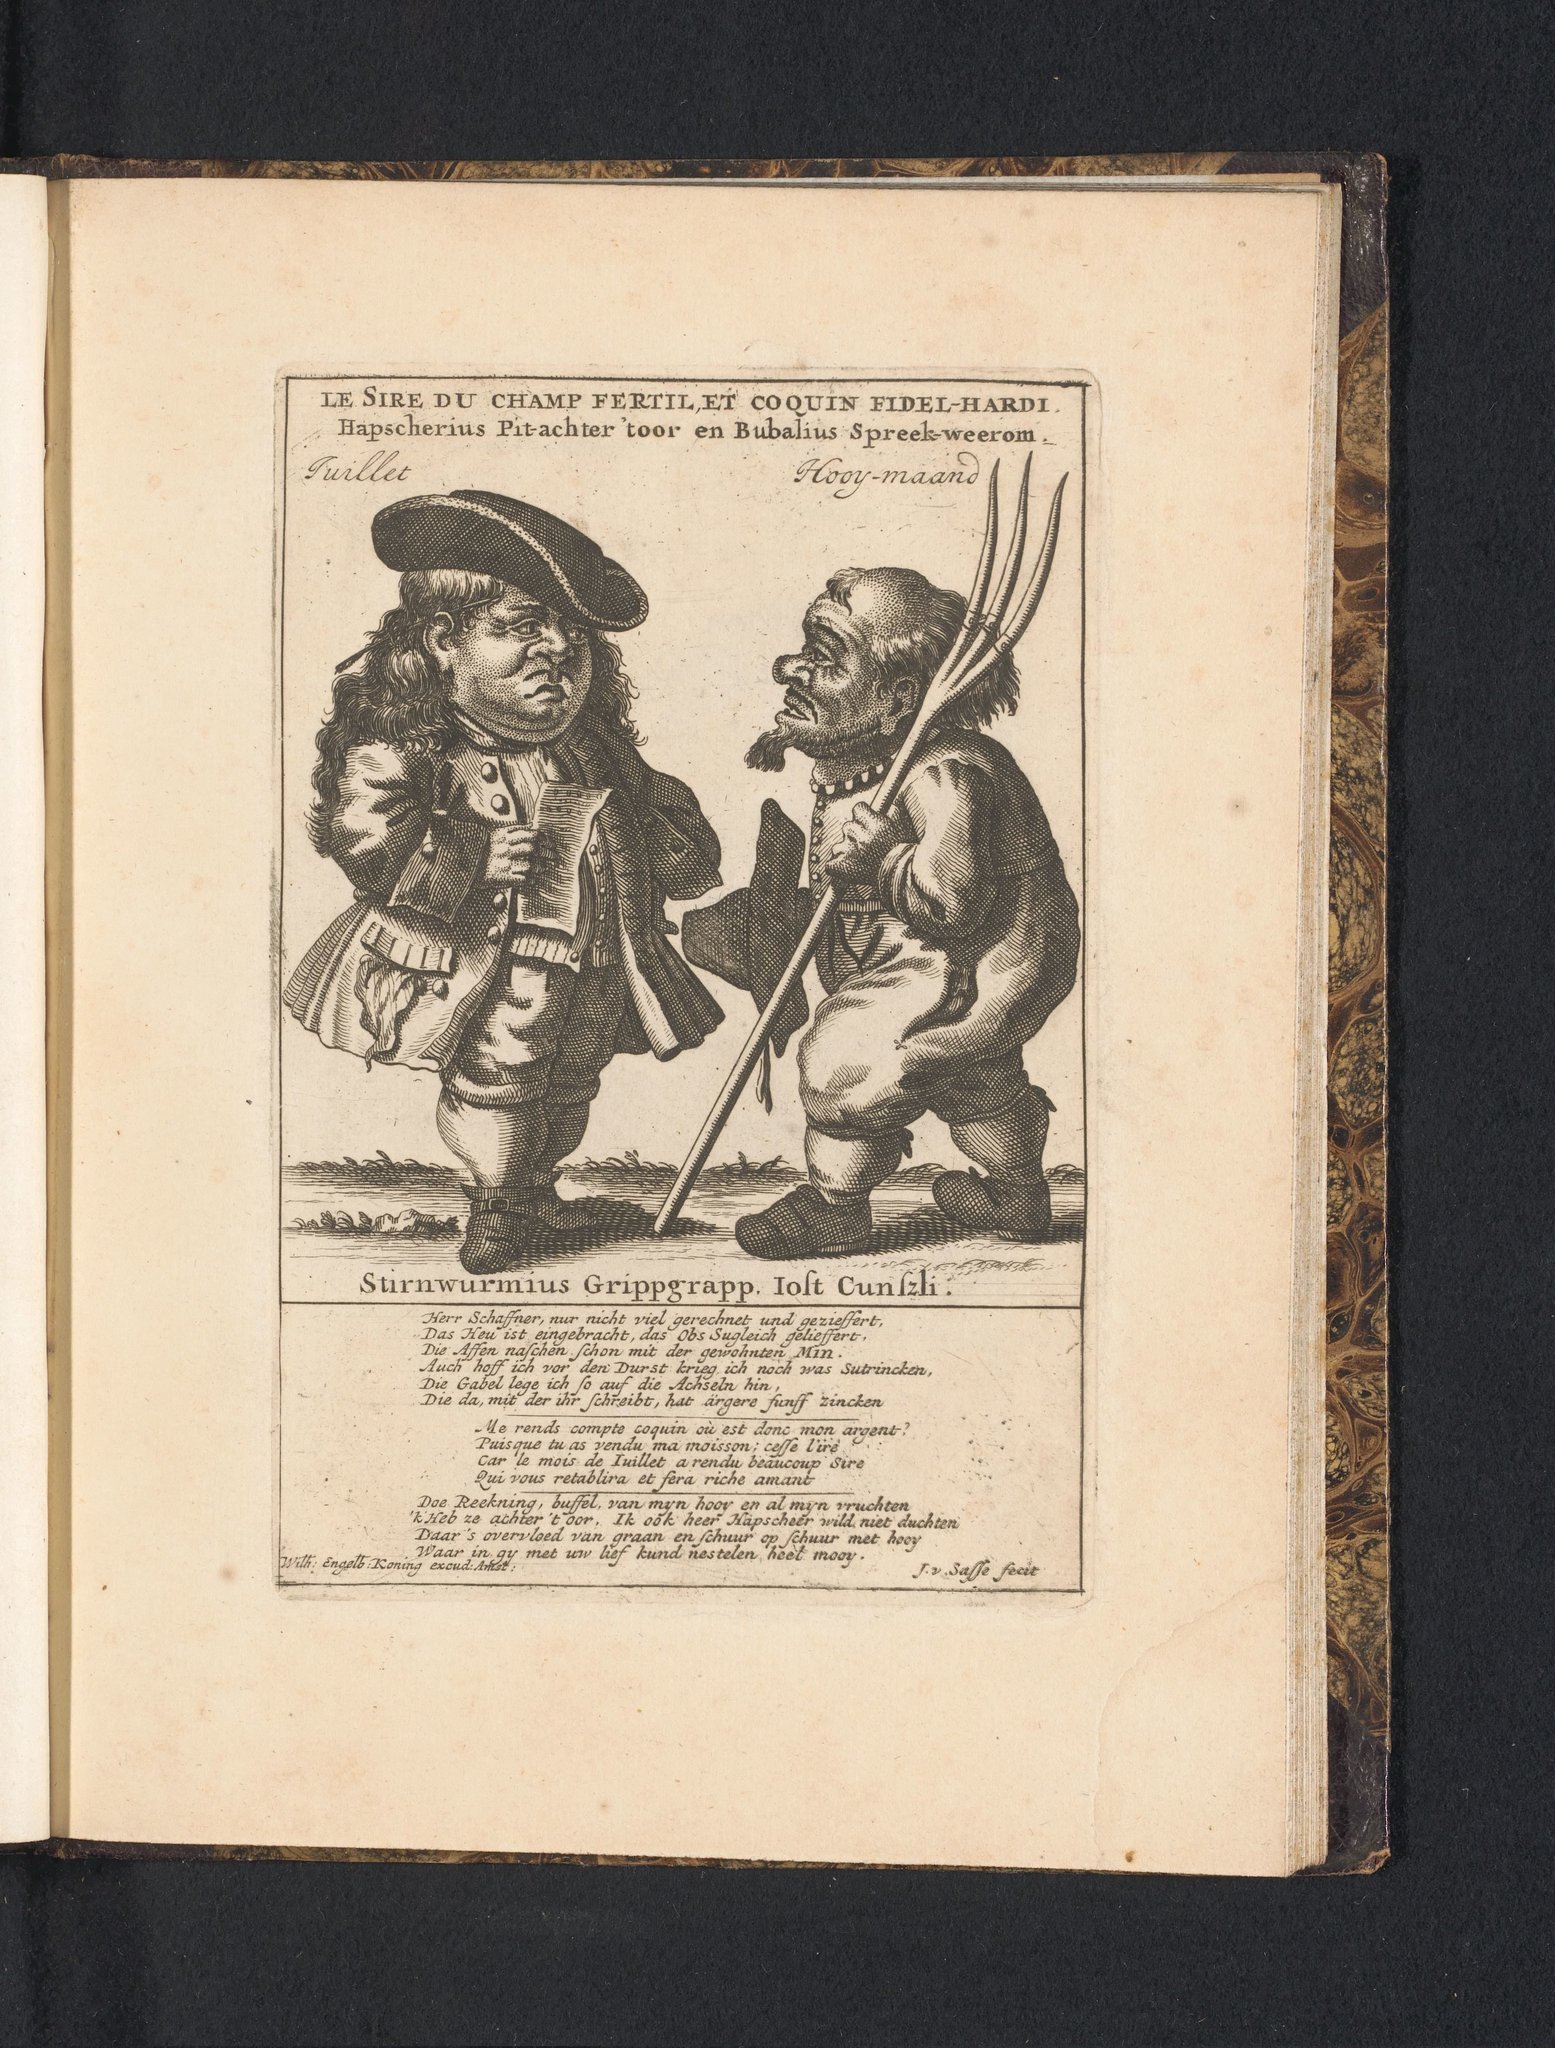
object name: print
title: Le Sire du Champ Fertil, et Coquin Fidel-Hardi / Hapscherius Pit-achter 'toor en Bubalius Spreek-weerom / Stirnwurmius Grippgrapp. Iost Cunszli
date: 1718-1720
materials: paper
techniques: engraving, etching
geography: northern netherlands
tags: caricatures (human types), little people, july and its 'labours'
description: Twee kleine mensen voor de maand juli (Hooimaand). Een landheer en een boer. In het onderschrift verzen in het Duits, Frans en Nederlands. Onderdeel van deel III (een serie van de twaalf maanden) in de tweede Nederlandse gebonden uitgave uit 1720 (en gerelateerd aan de Windhandel in dat jaar) van een serie karikaturen van kleine mensen, bekend als Het Dwergentooneel.